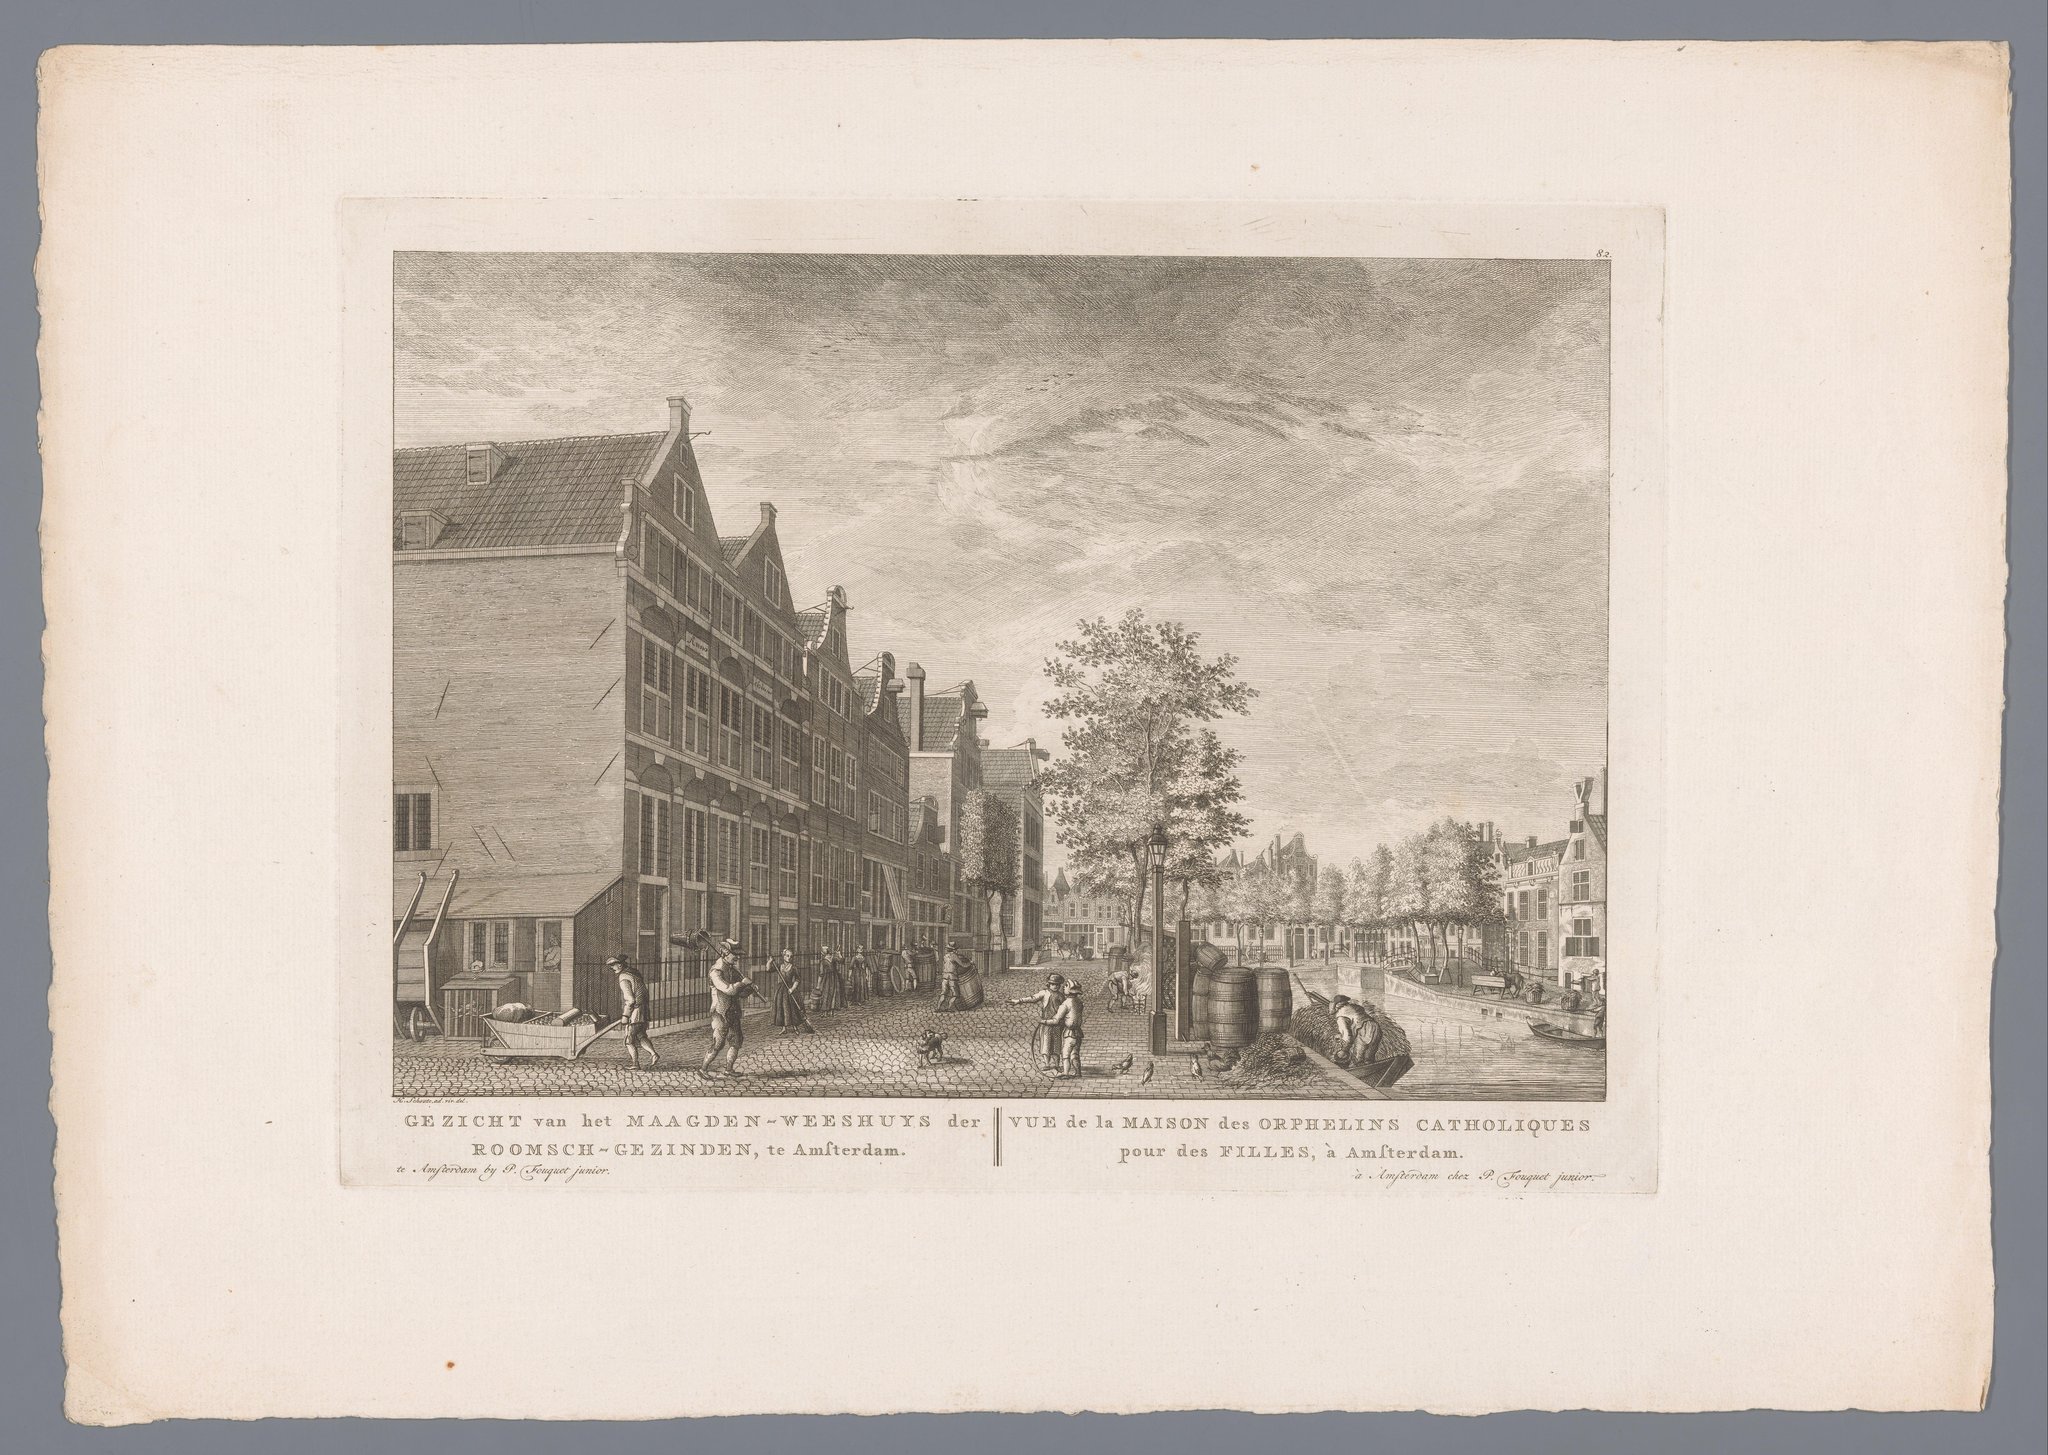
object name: print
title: Gezicht van het Maagden-Weeshuys der Roomsch-gezinden, te Amsterdam / Vue de la maison des orphelins Catholiques pour des filles, à Amsterdam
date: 1778-1783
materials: paper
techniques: engraving, etching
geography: amsterdam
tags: orphanage, bridge in city across river, canal, etc.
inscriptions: collector's mark: Lugt 2233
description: Prent uit een van de edities van de Atlas Fouquet: Afbeeldingen van de wyd-vermaarde koopstad Amsterdam benevens des zelvs voornaamste gebouwen en gezigten alle naar het leeven getekend / Receuil des edifices les plus considerables et des plus belles vues, de la fameuse ville d'Amsterdam, dessinées d'après nature. Amsterdam: Pierre Fouquet, 1778-1783. En: Nieuwe atlas, van de voornaamste gebouwen en gezigten der stad Amsterdam, met derzelver beknopte beschryvingen. 2 dln. Amsterdam: Daniël Jean Changuion en Petrus den Hengst [in opdracht van Pierre Fouquet], 1783. Een latere staat komt voor in: Nieuwe atlas, van de voornaamste gebouwen en gezigten der stad Amsterdam. Met derzelver beknopte beschryvingen. Amsterdam: Evert Maaskamp, 1805.